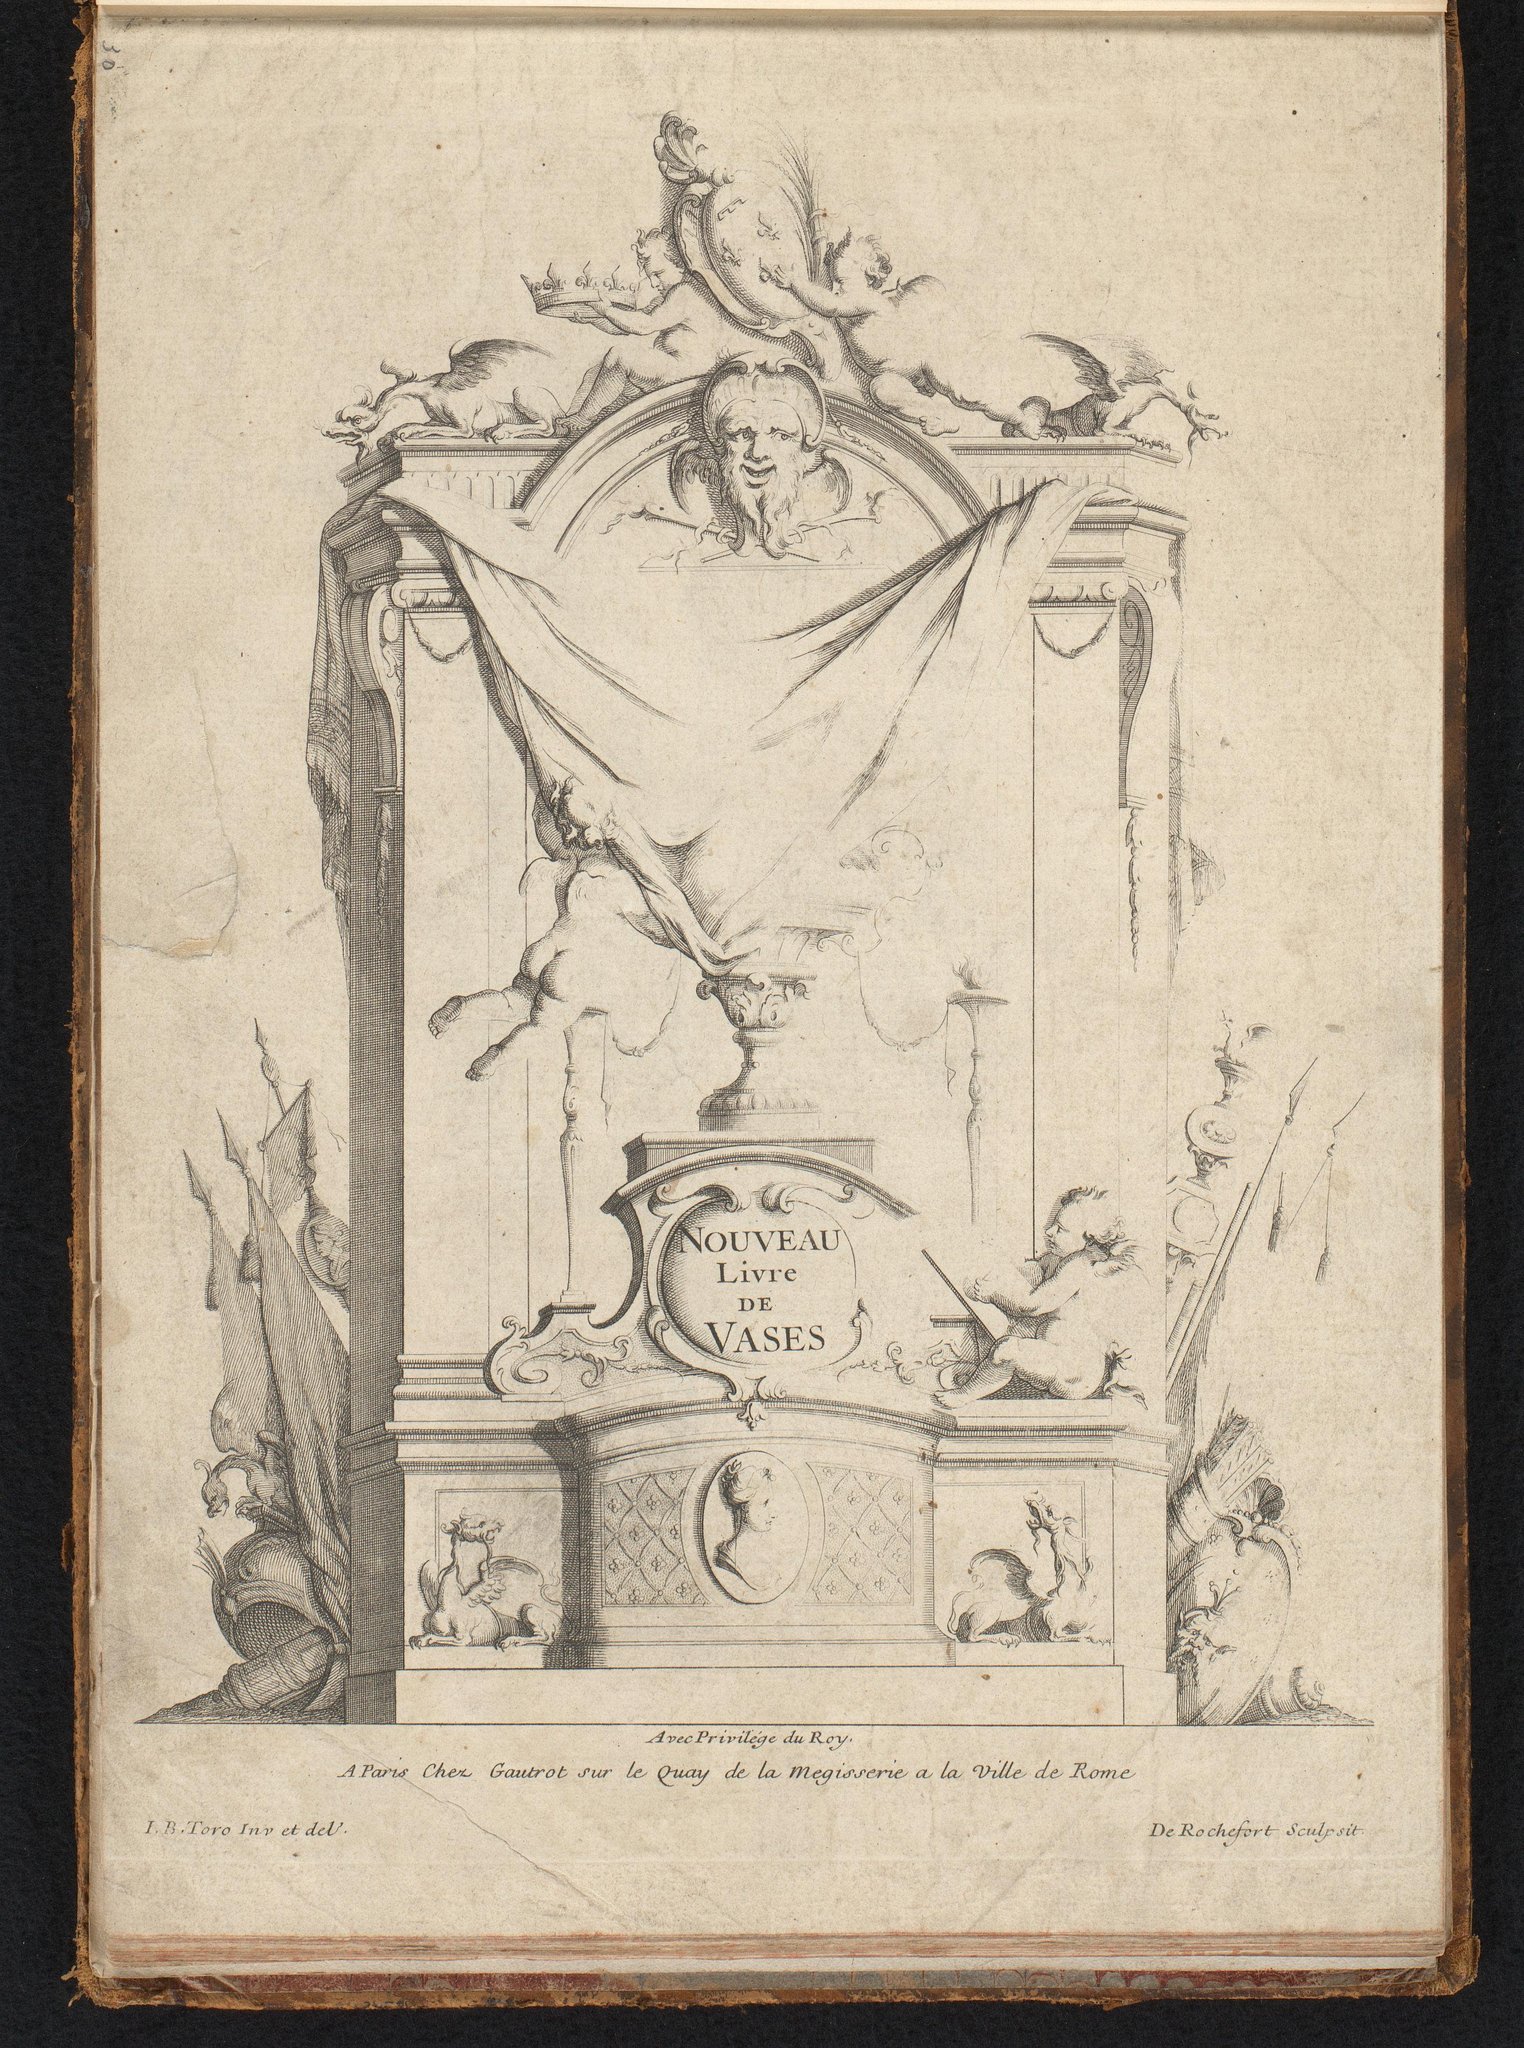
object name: print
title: Ontwerpen voor ornamenten met vazen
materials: paper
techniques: engraving, etching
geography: france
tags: vase ~ ornament, cupids: 'amores', 'amoretti', 'putti', garden vase